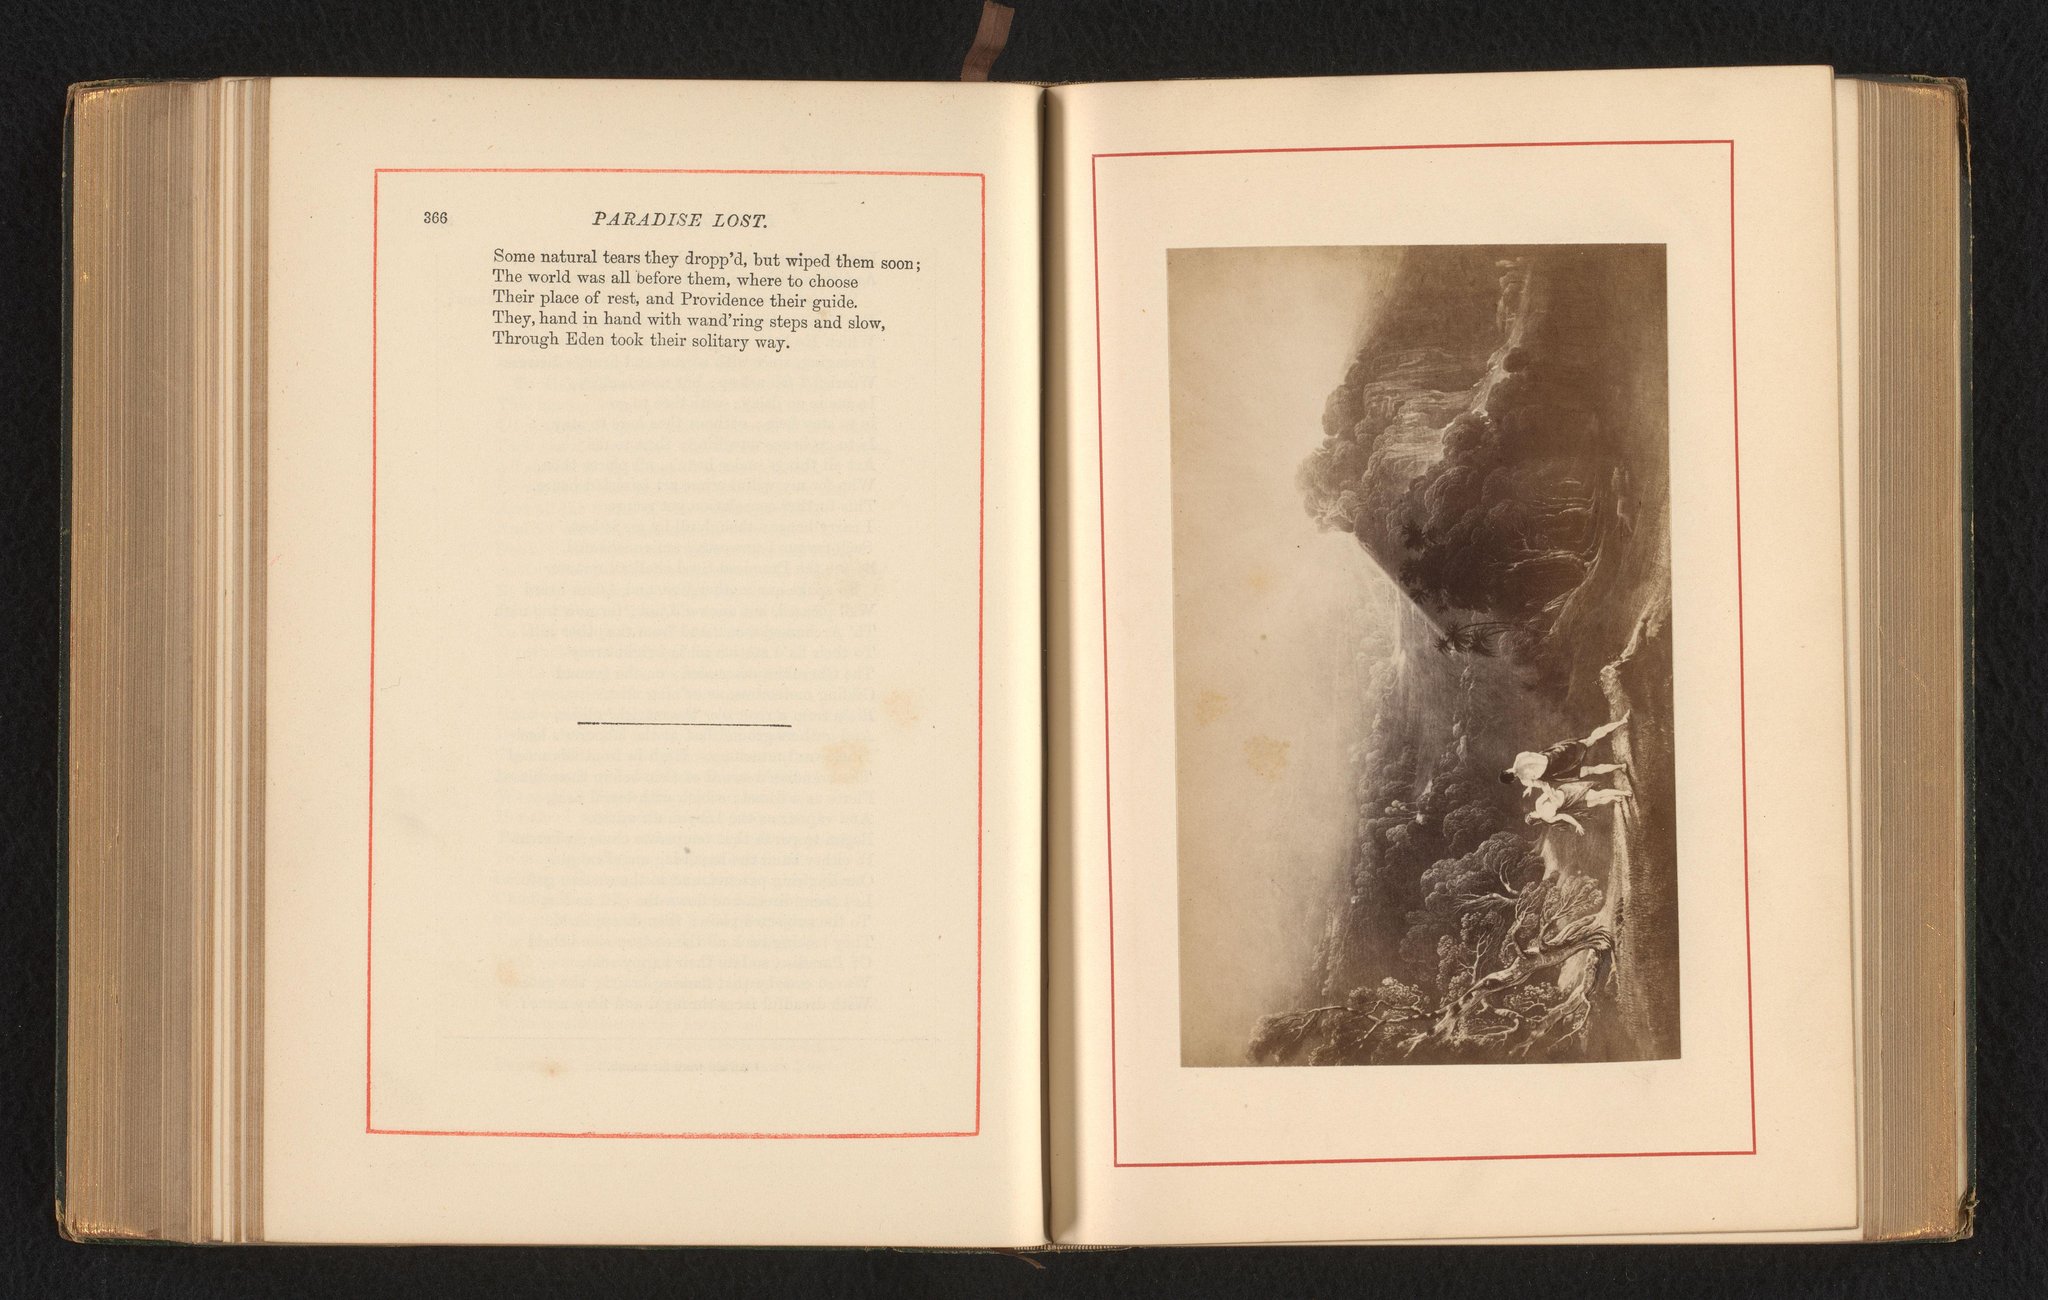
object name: page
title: Fotoreproductie van een schilderij van Adam en Eva uit het paradijs verdreven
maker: Anonymous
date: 1866-1890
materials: paper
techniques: albumen print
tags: expulsion of adam and eve from paradise (genesis 3:22-24), picture, painting